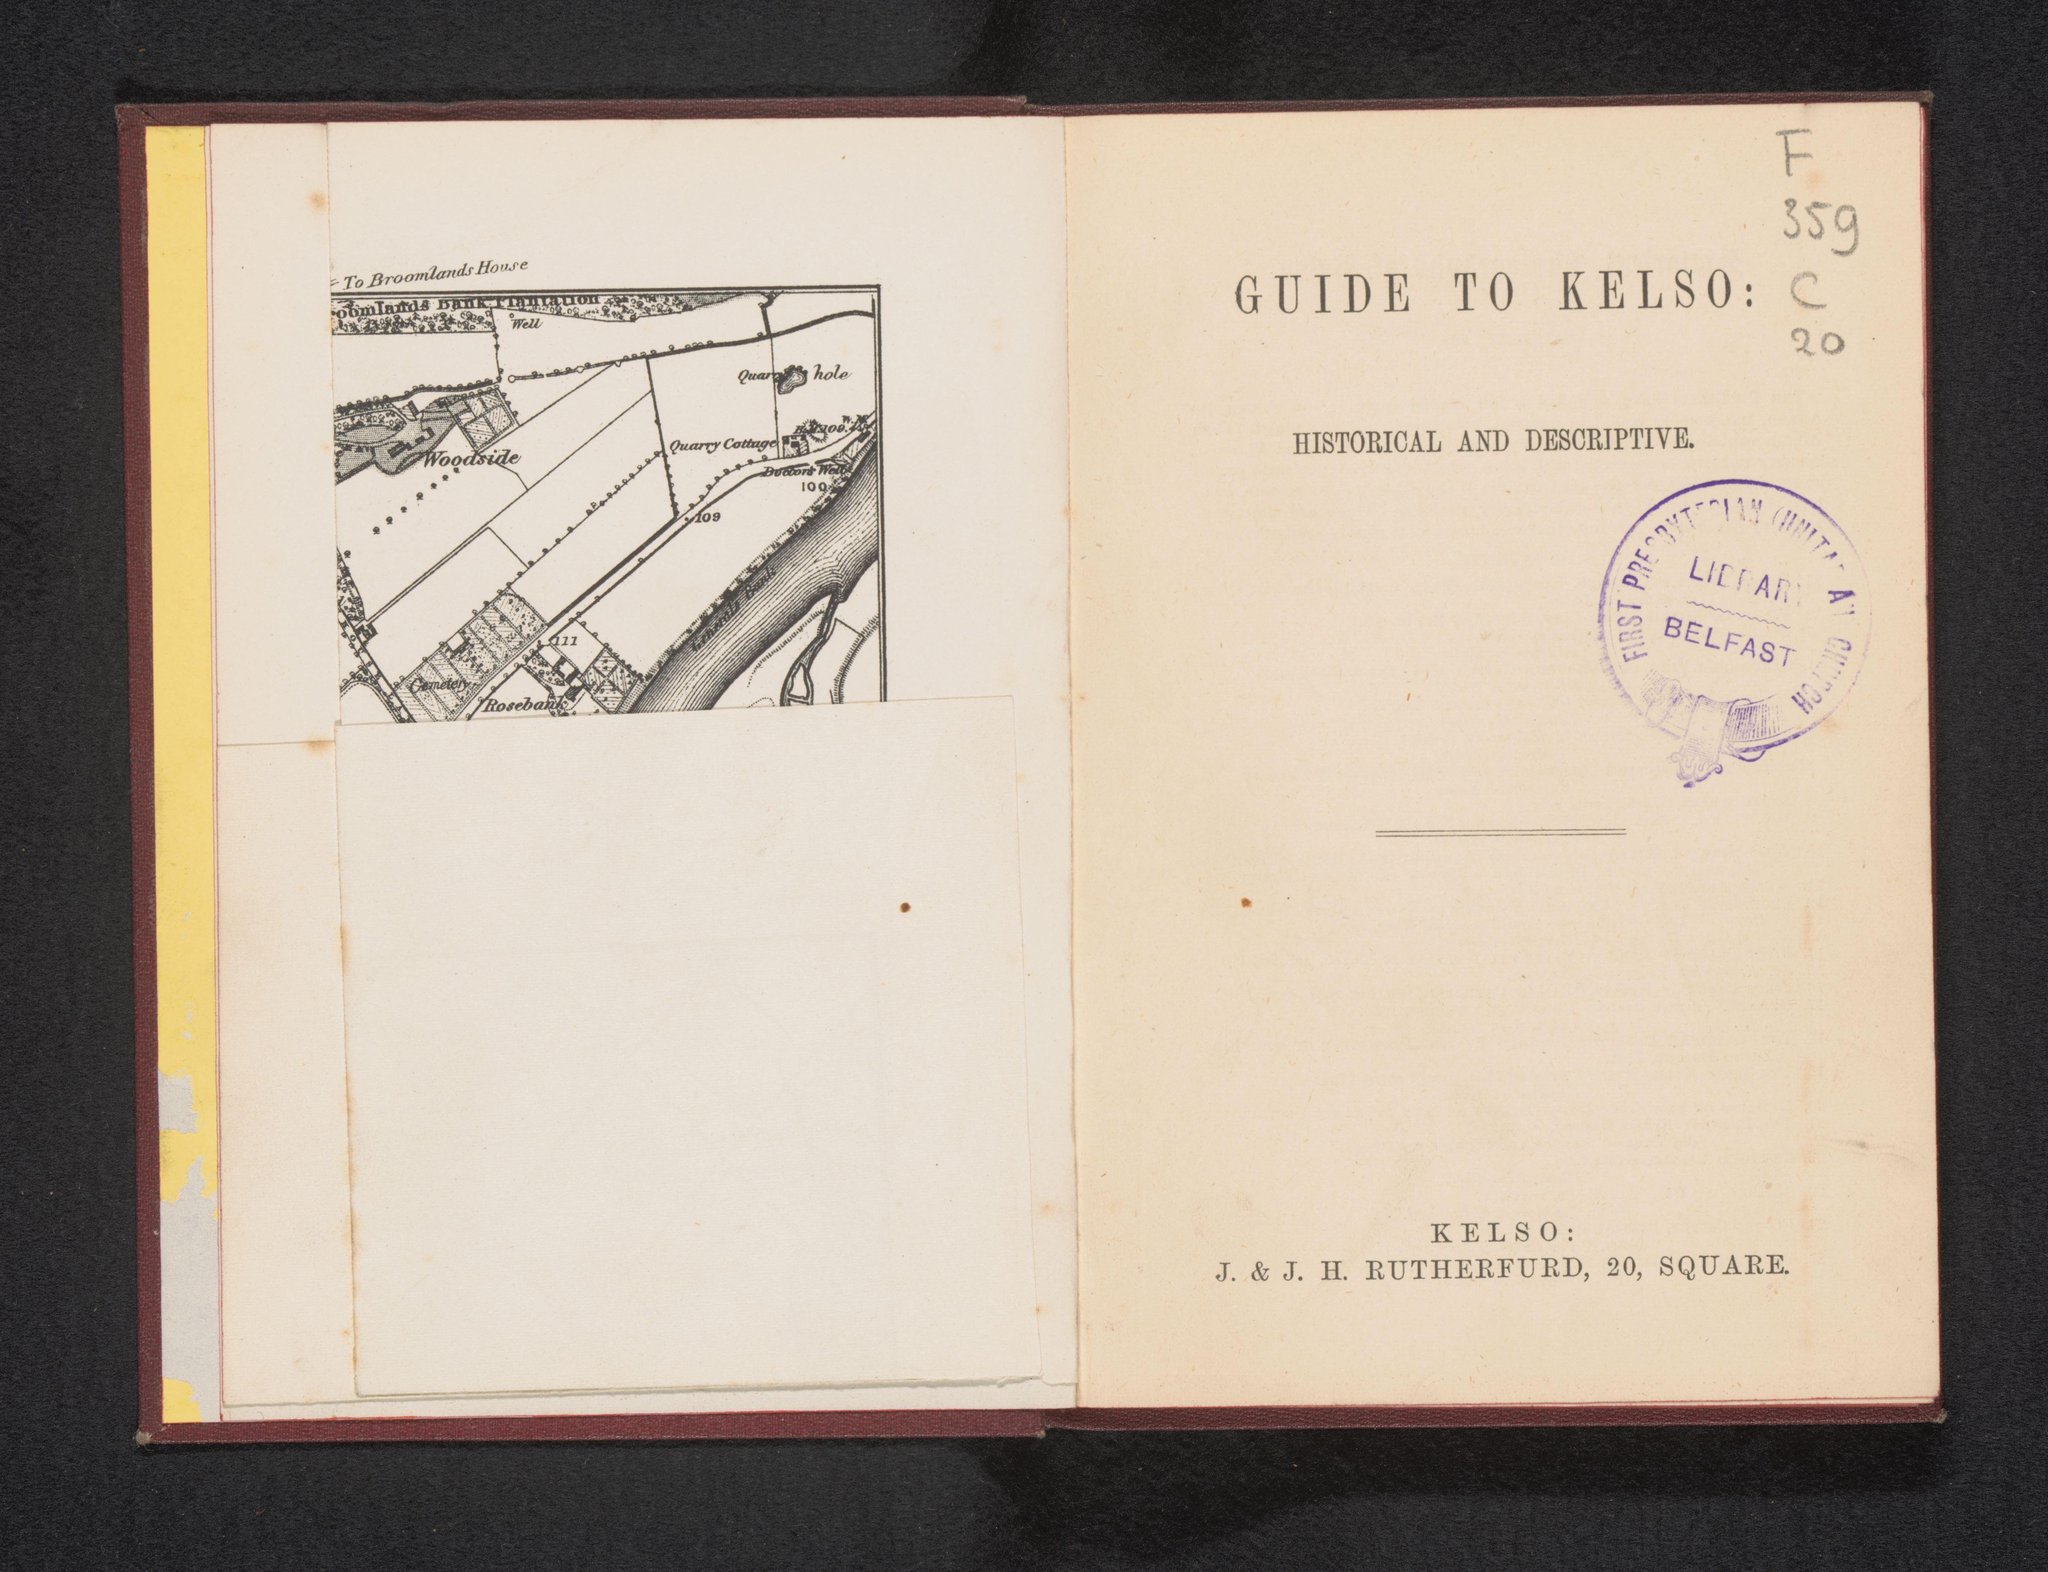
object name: book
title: Guide to Kelso : historical and descriptive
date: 1880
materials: cardboard, linen, paper, photographic support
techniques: albumen print, lithograph, printing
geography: kelso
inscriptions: annotation: ‘APR/ 1993’, annotation: ‘Ads at back./ $22-/ 5001’, bookplate: ‘LIBRARY/ OF/ First Presbyterian Church/ BELFAST/ (...)’